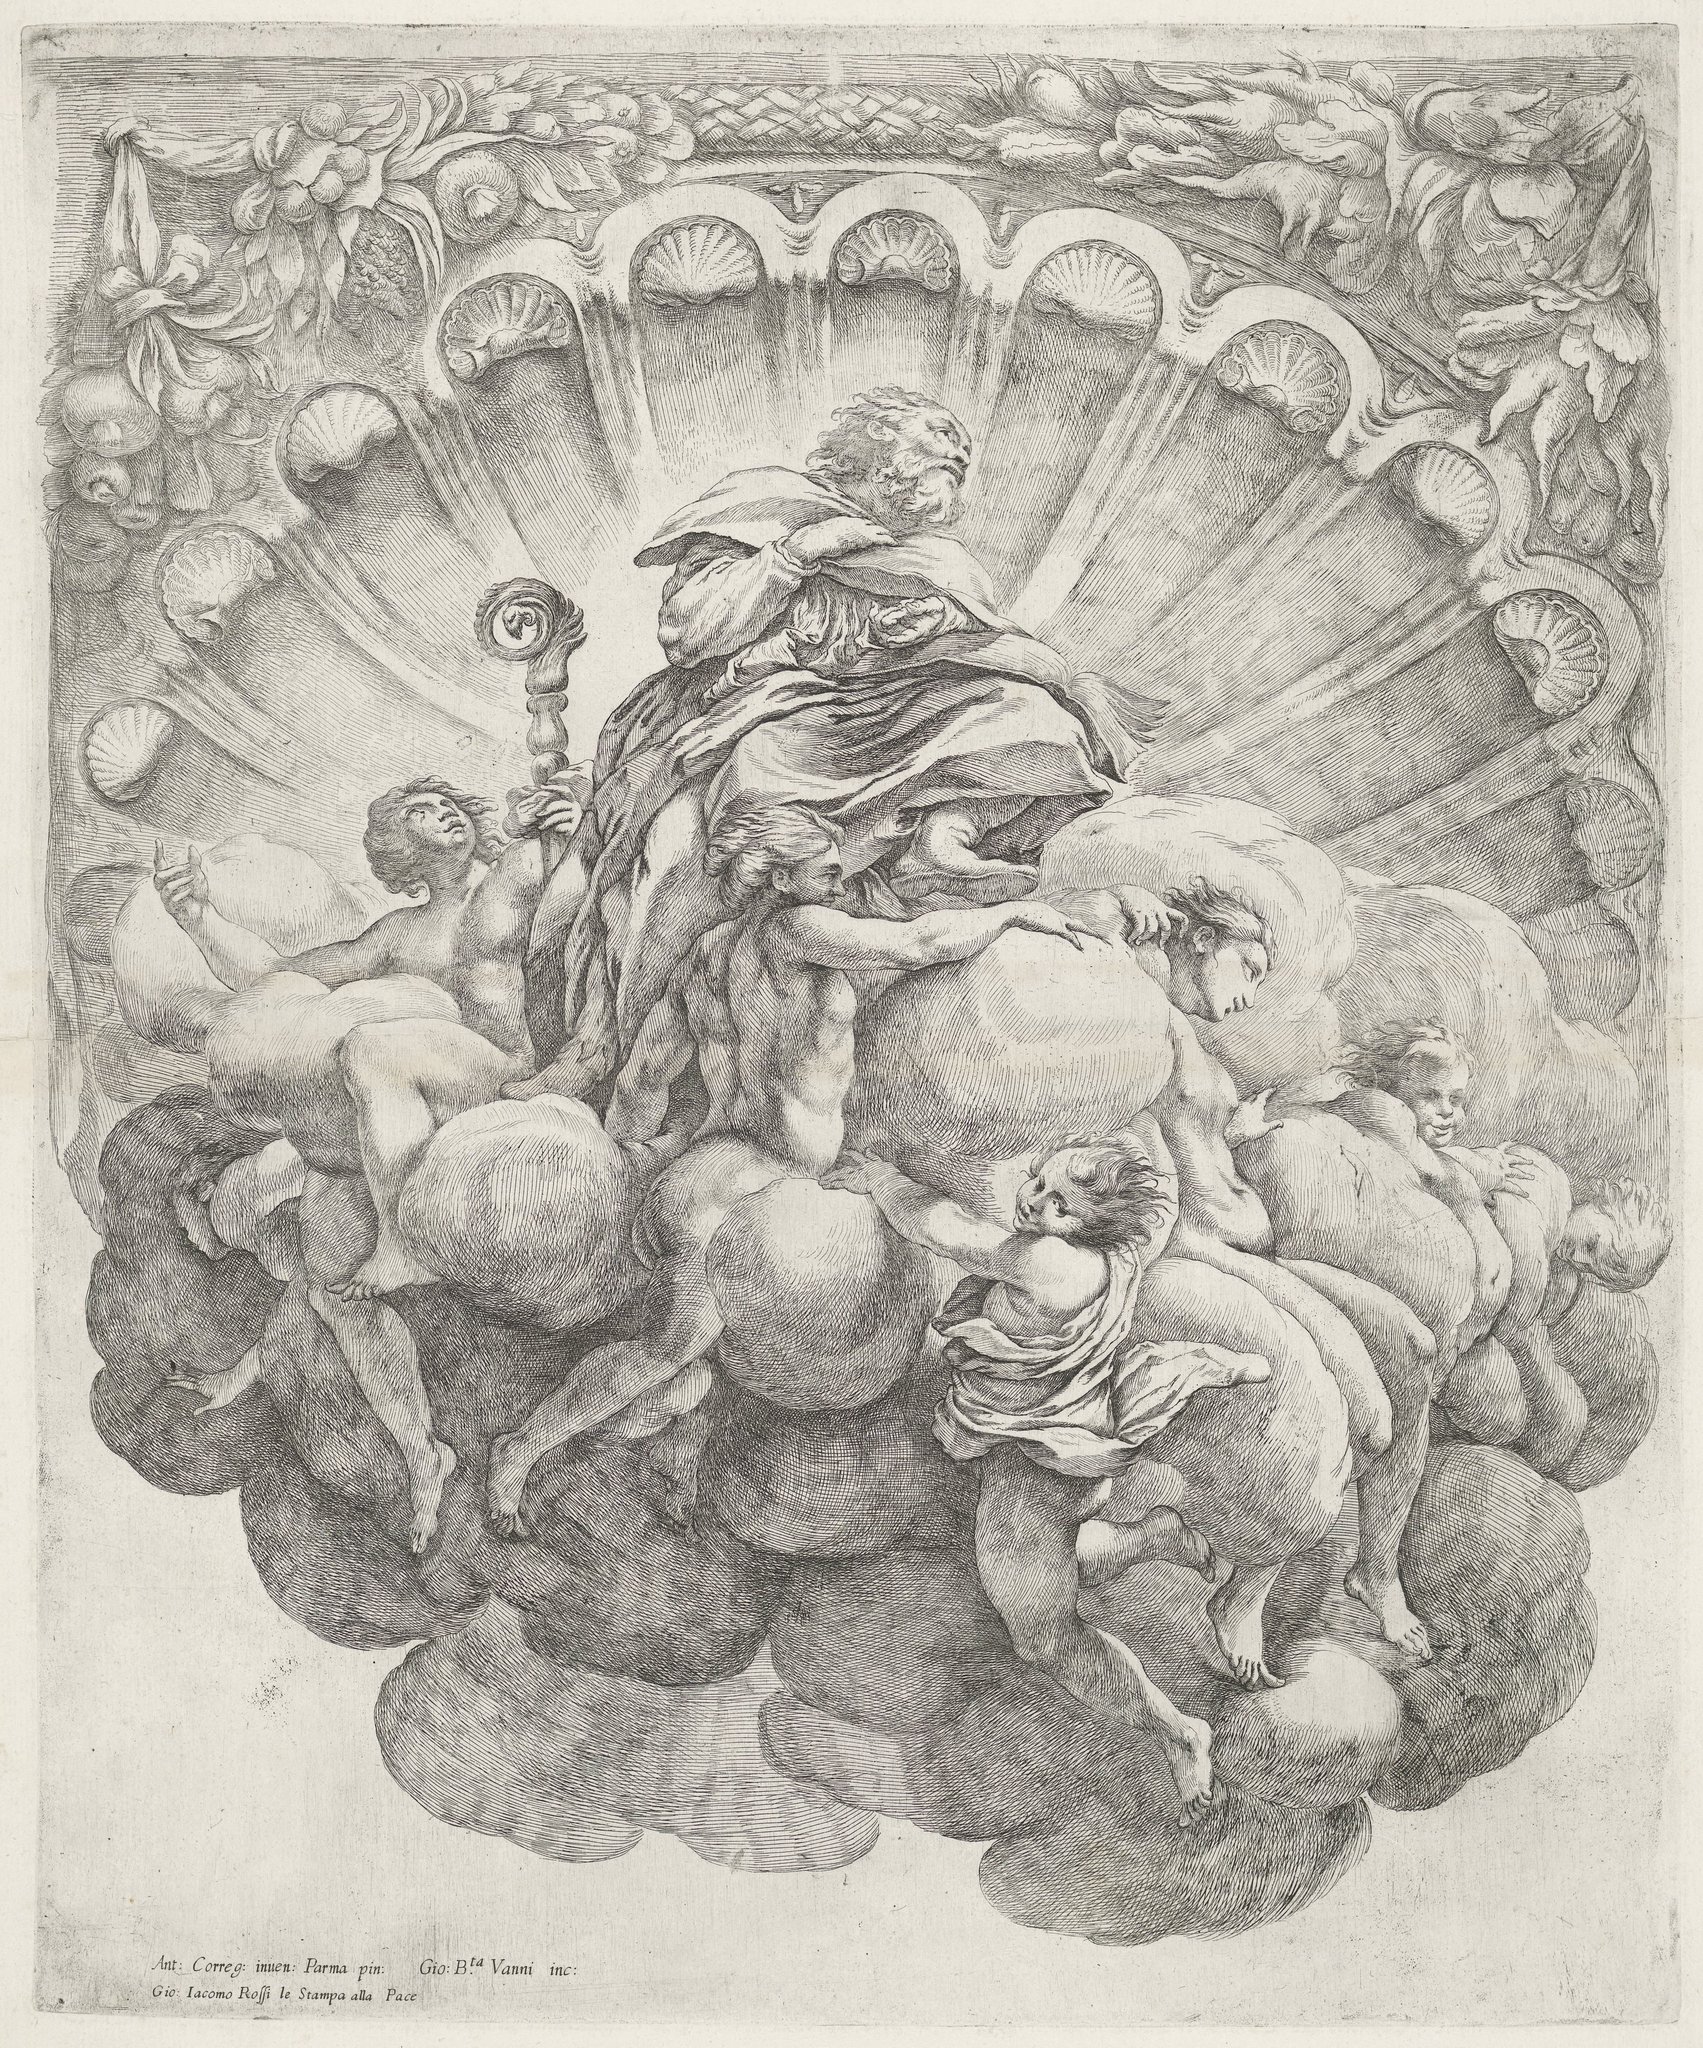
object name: print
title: Koepeldecoraties door Correggio in de S. Giovanni Evangelista in Parma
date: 1609-1660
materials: paper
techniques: etching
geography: parma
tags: archbishop, bishop, etc. (roman catholic), angels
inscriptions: collector's mark: Lugt 240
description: Prent uit een reeks van 4 prenten naar de koepeldecoraties door Correggio in de S. Giovanni Evangelista in Parma.